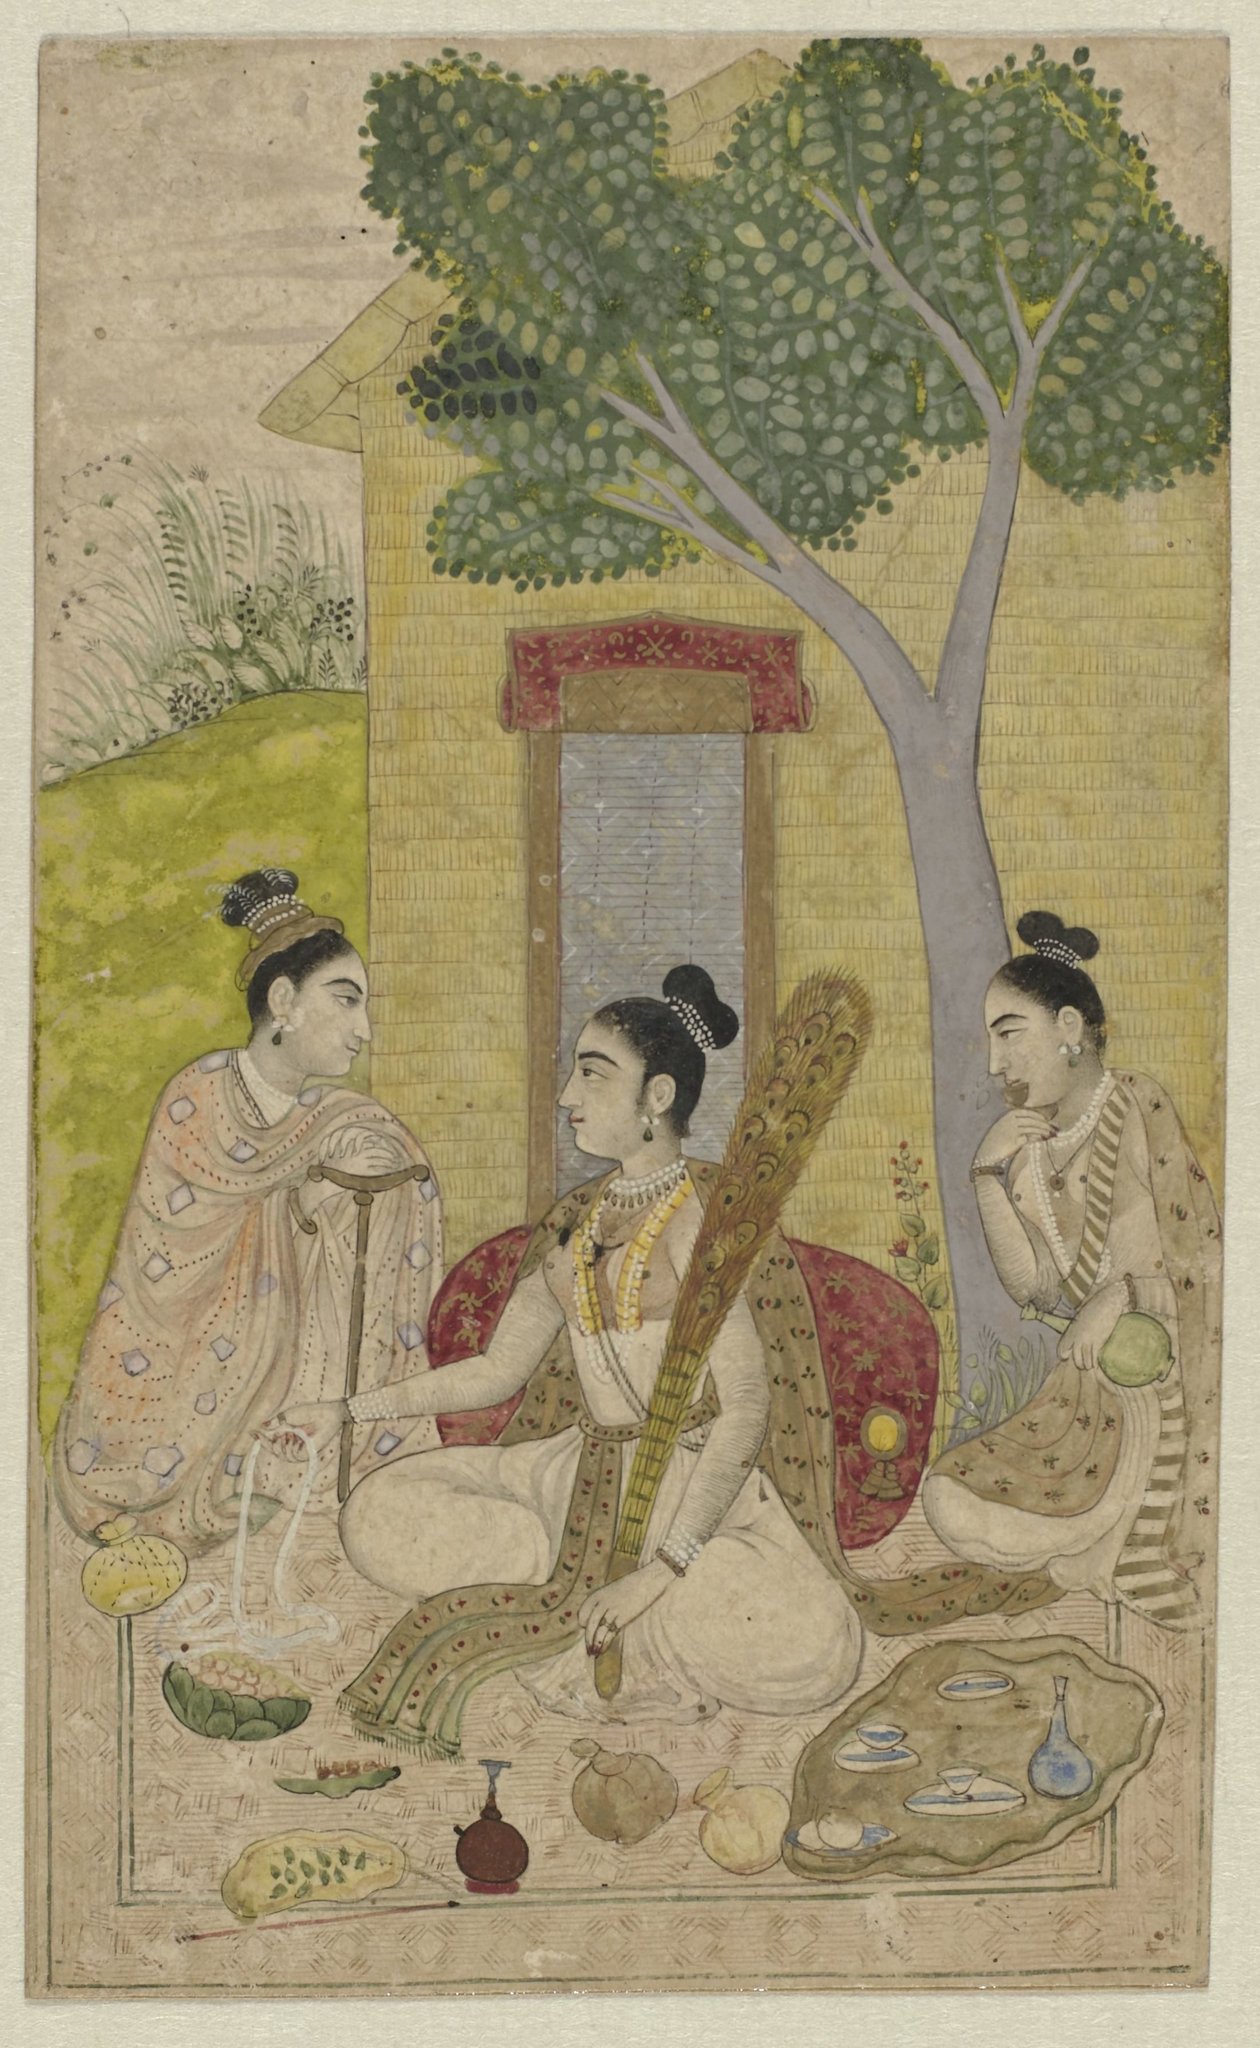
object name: indian miniature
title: Drie yogini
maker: Anonymous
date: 1680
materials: paper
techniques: brush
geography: deccan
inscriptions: inscription: ‘.’